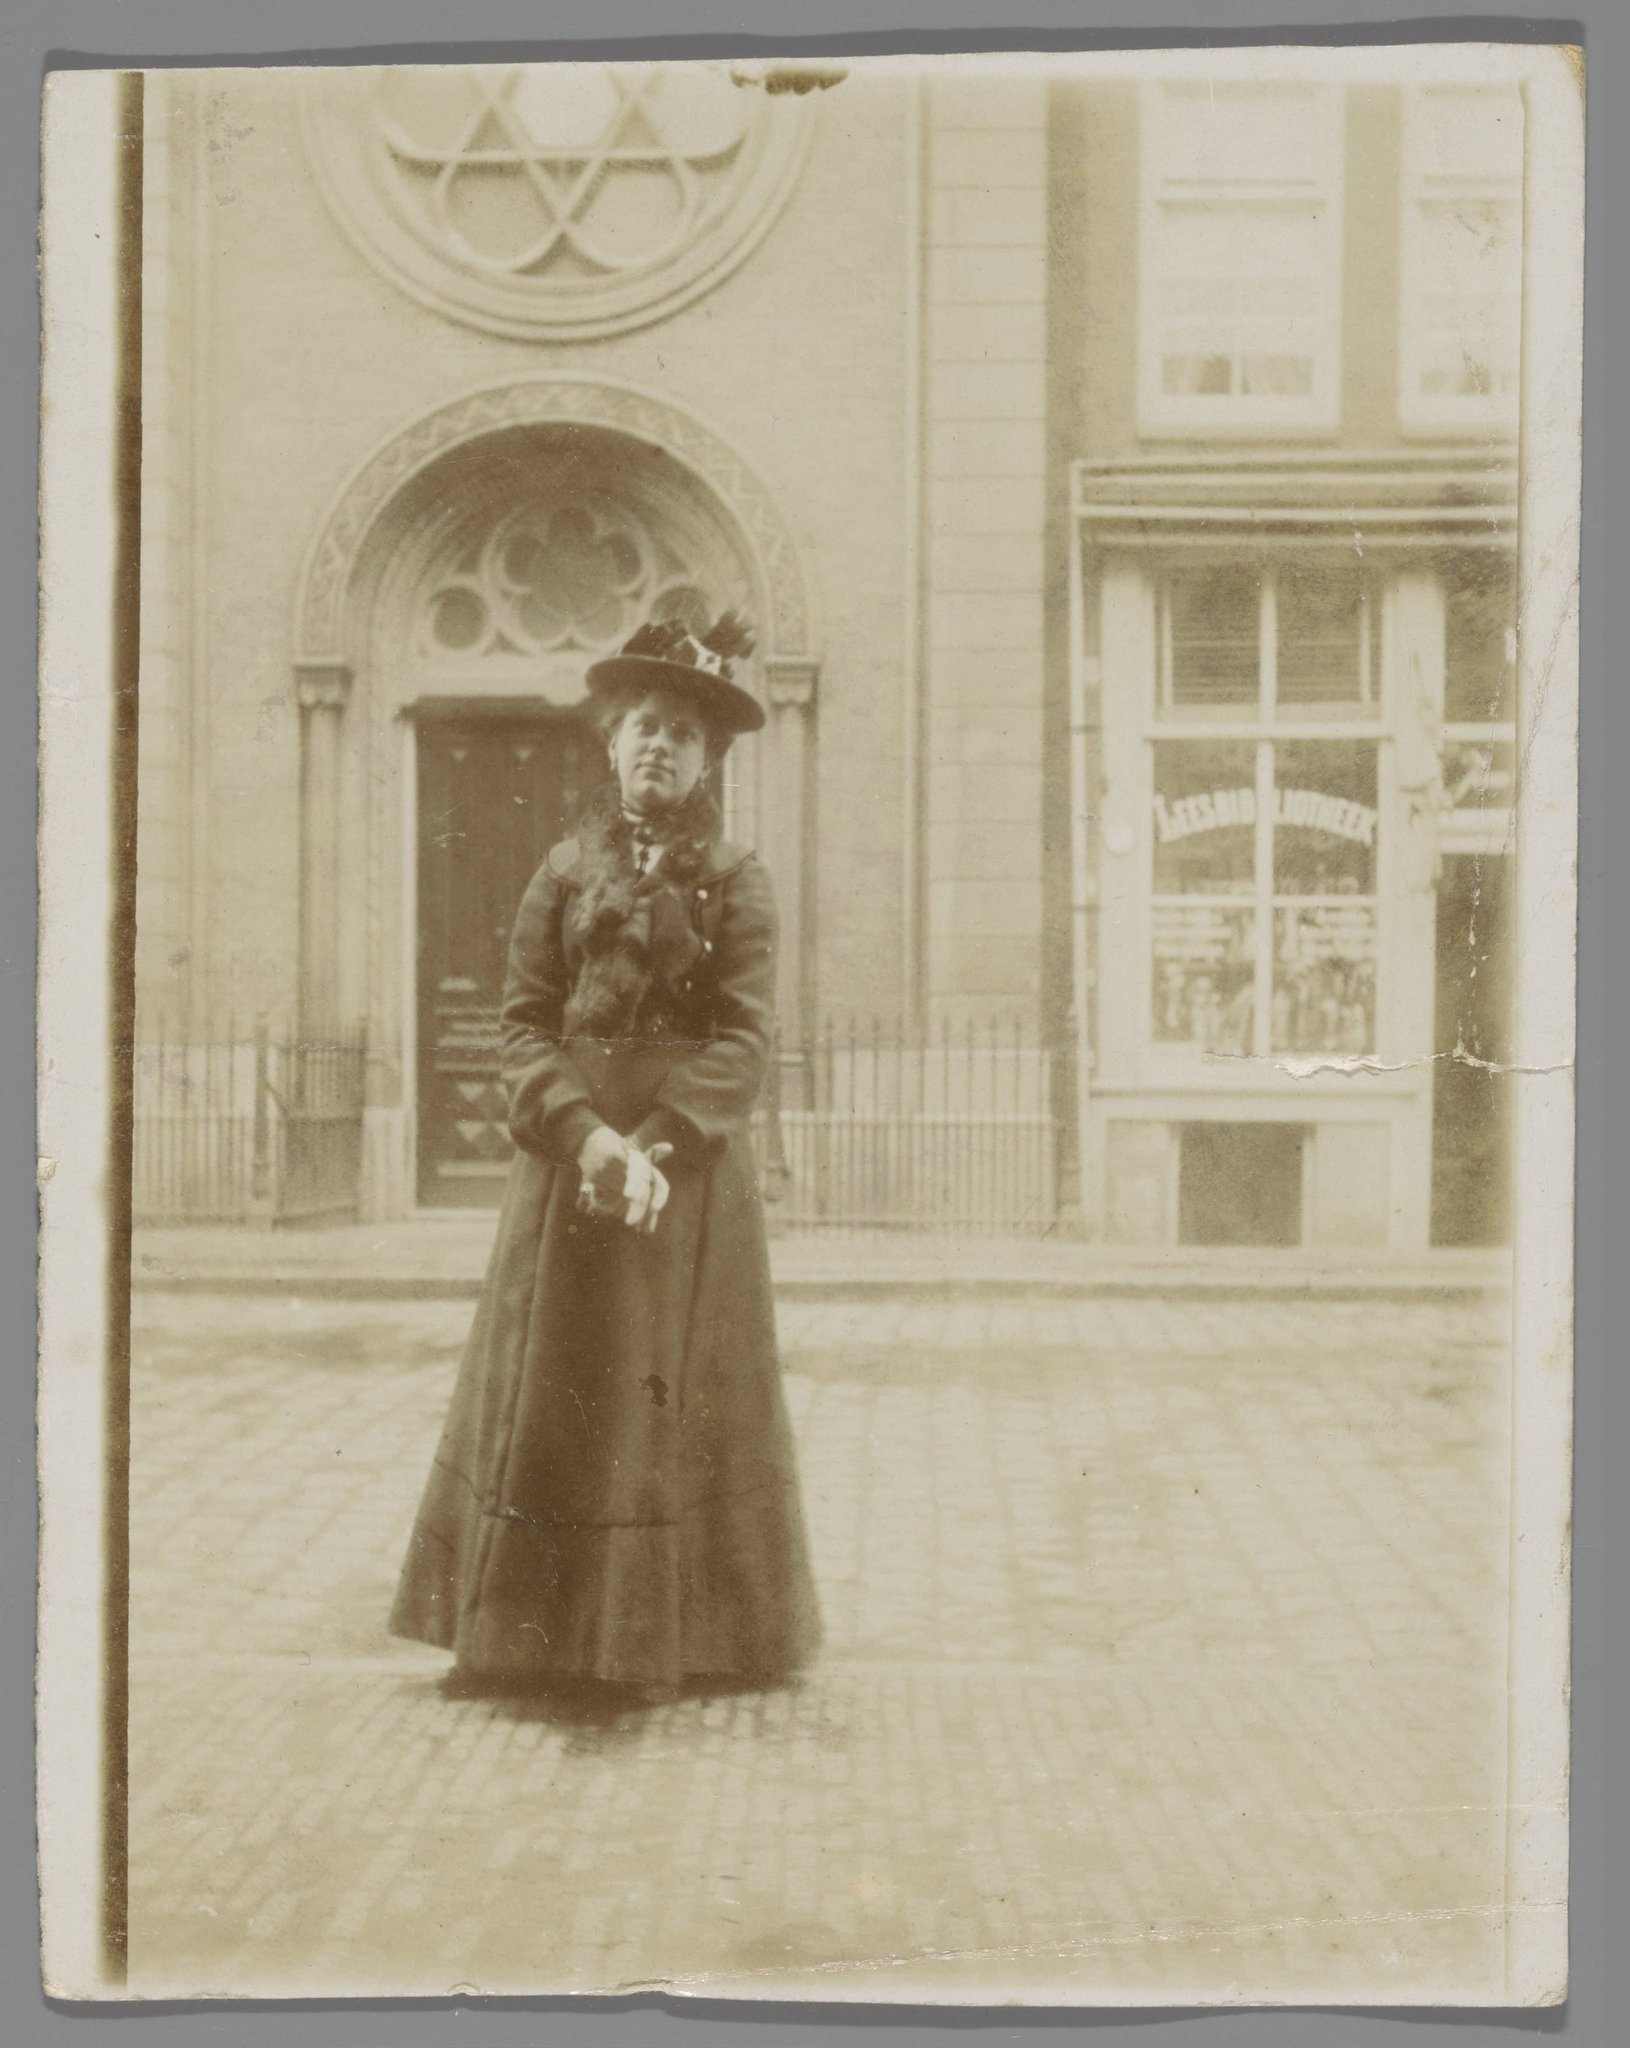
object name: photograph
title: Portret van een onbekende jonge vrouw op straat, staande voor een kerk en een bibliotheek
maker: Anonymous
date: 1900-1910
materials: paper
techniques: gelatin silver print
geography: netherlands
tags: anonymous historical person portrayed - bb - woman